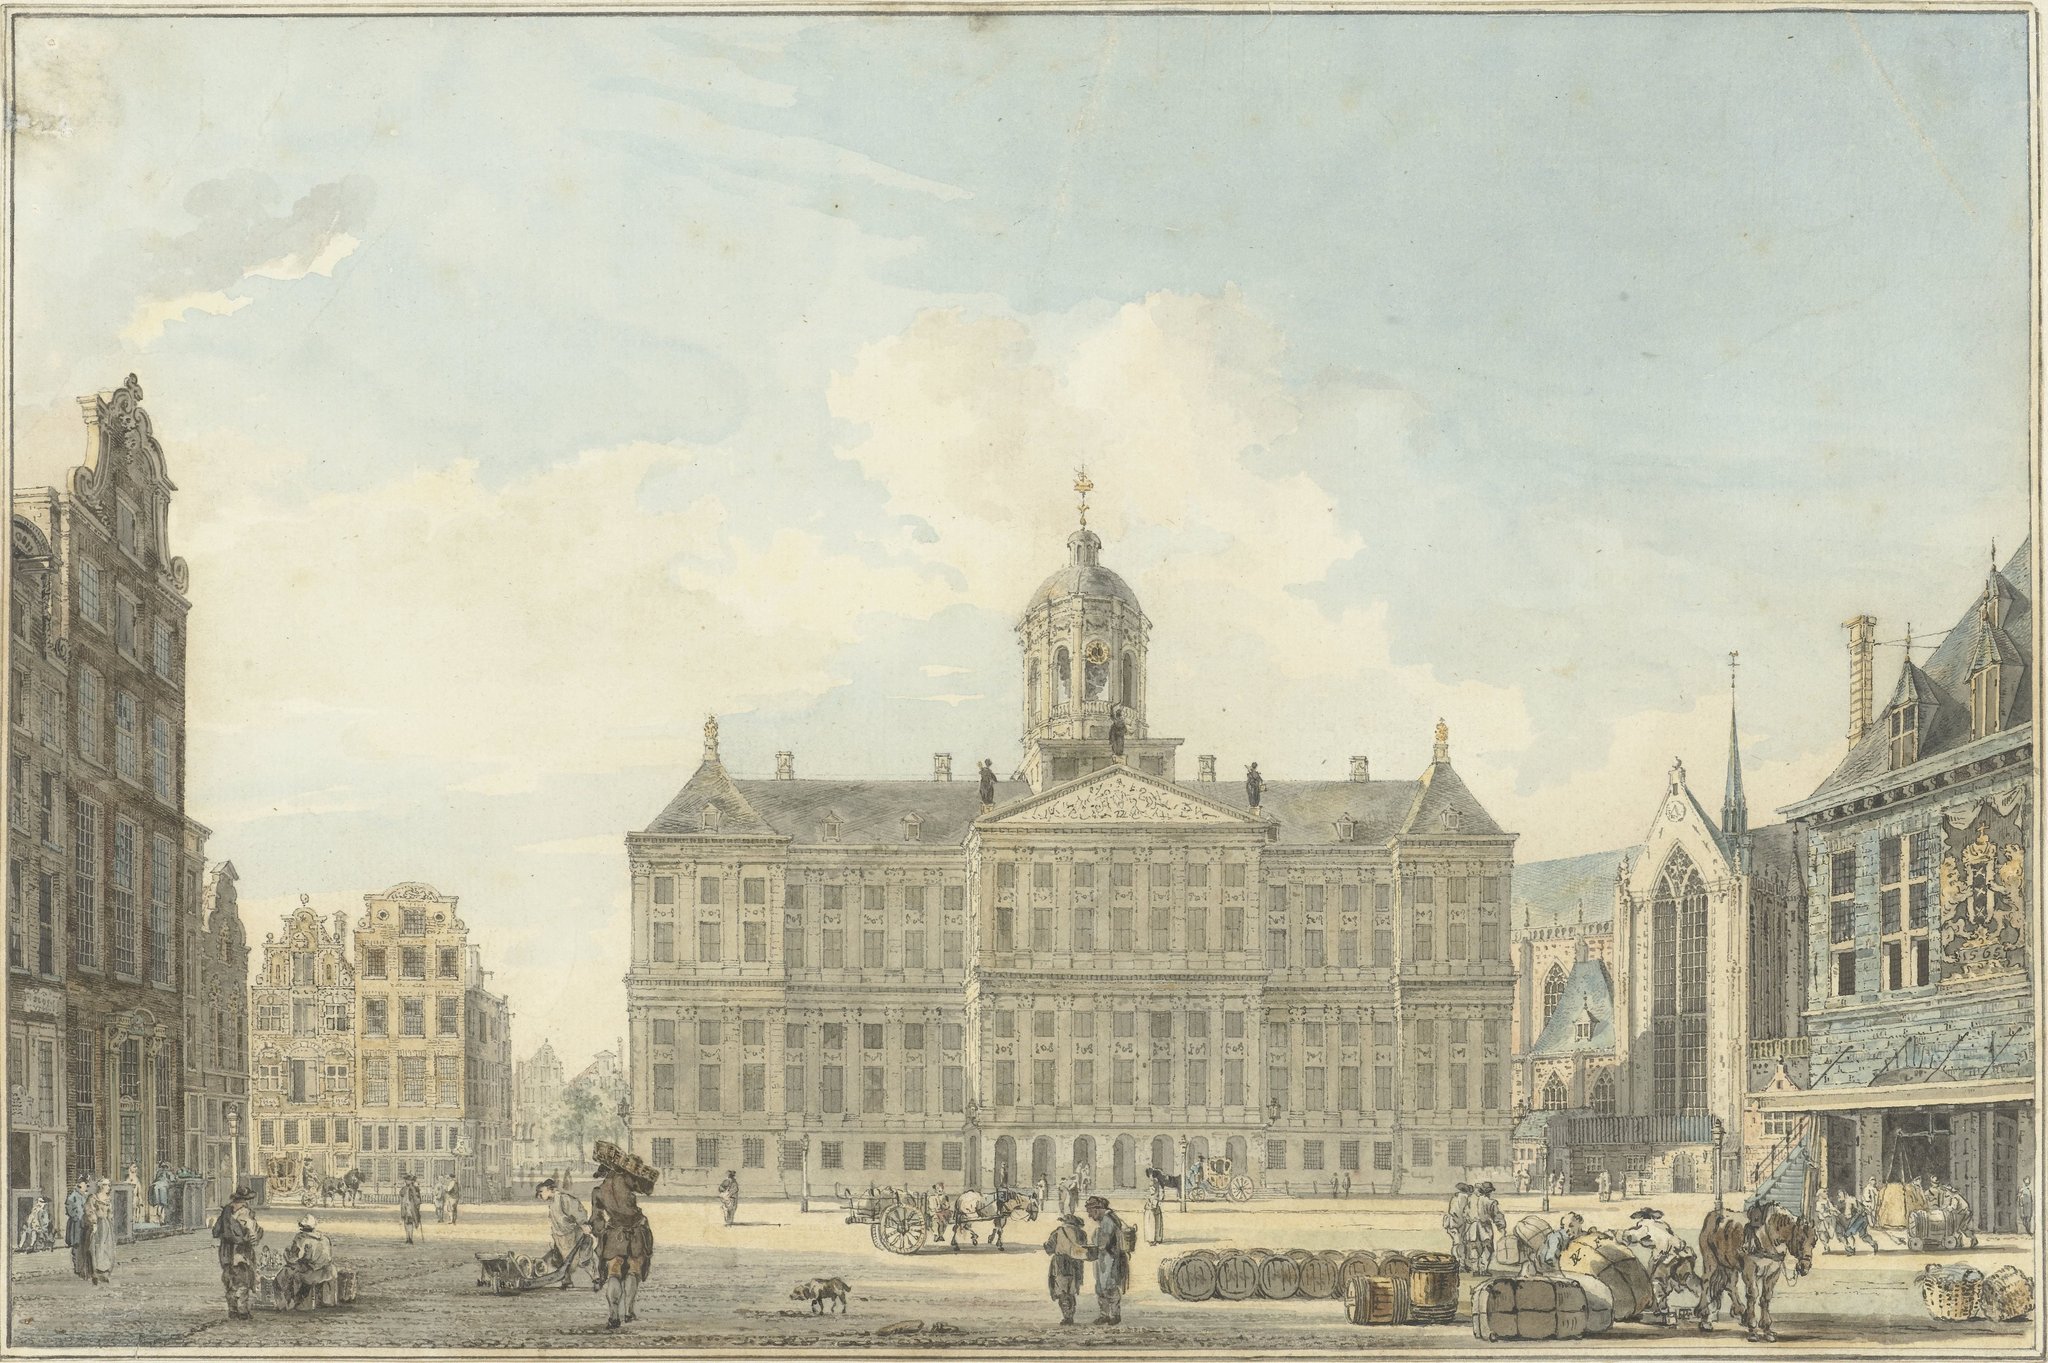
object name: watercolor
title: Amsterdam, de Dam met het Stadhuis en de Waag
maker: reinier vinkeles (i)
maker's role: draughtsman, print maker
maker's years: 1741-1816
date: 1764-1767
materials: ink, paper, watercolor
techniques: brush, pen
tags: church (exterior), townhall, weigh-house, amsterdam